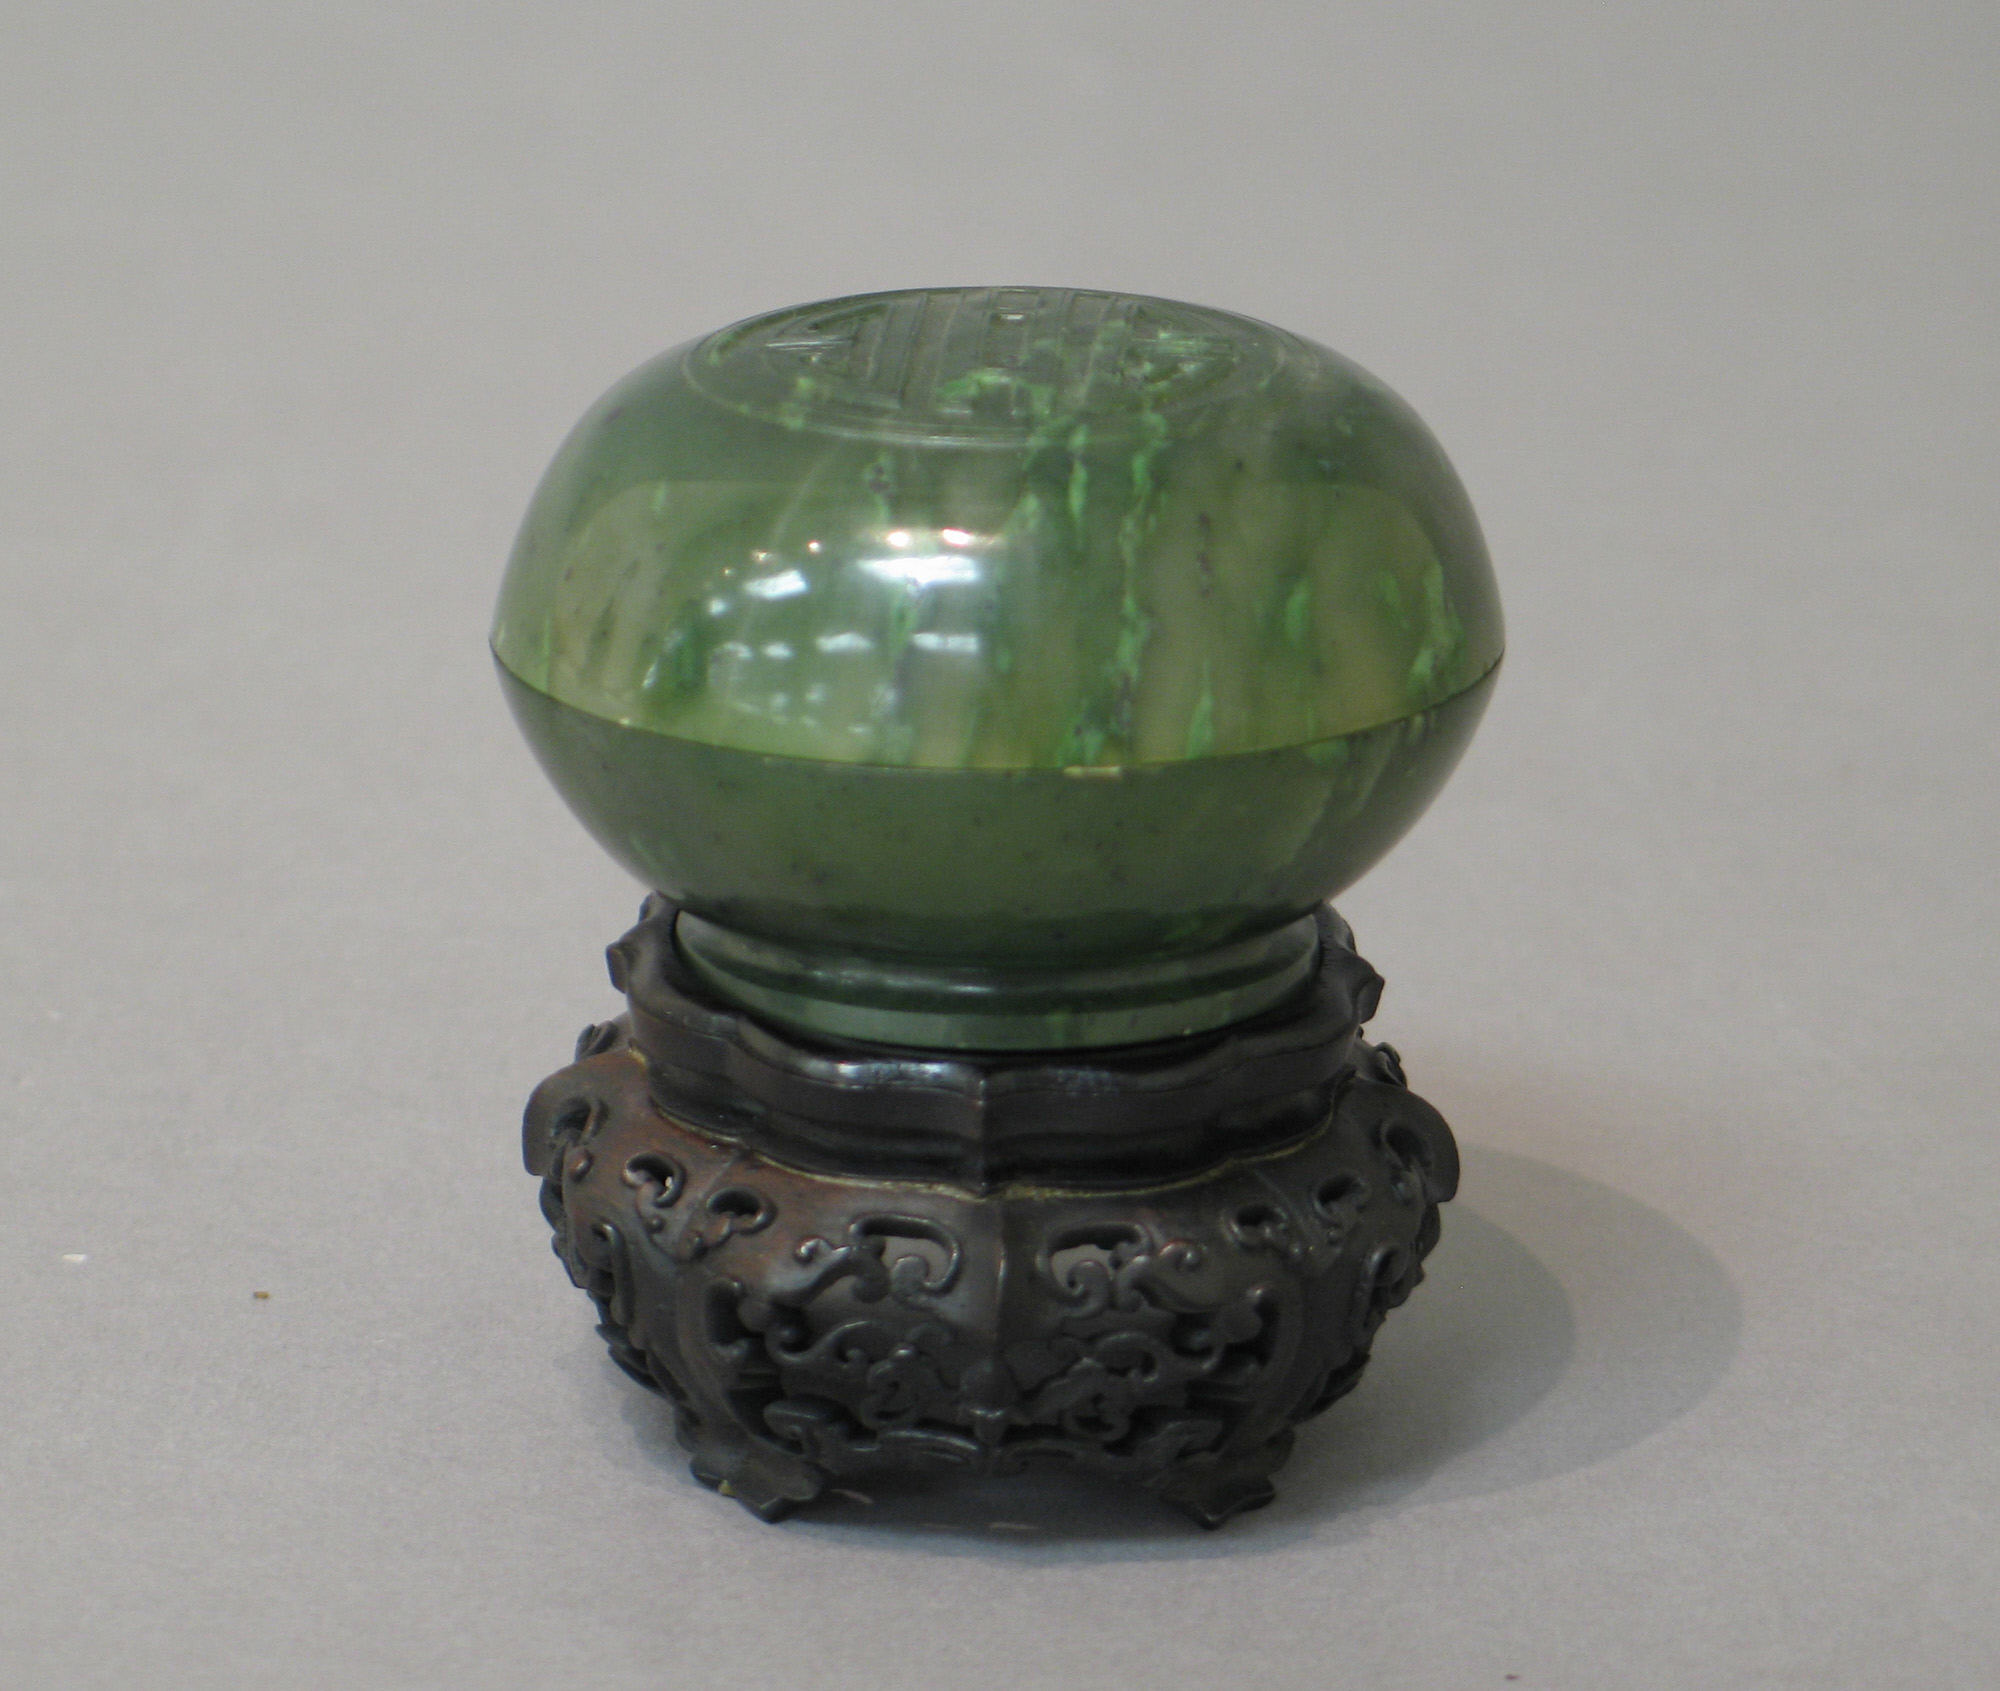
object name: box with cover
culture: chinese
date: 1736-1795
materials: jade